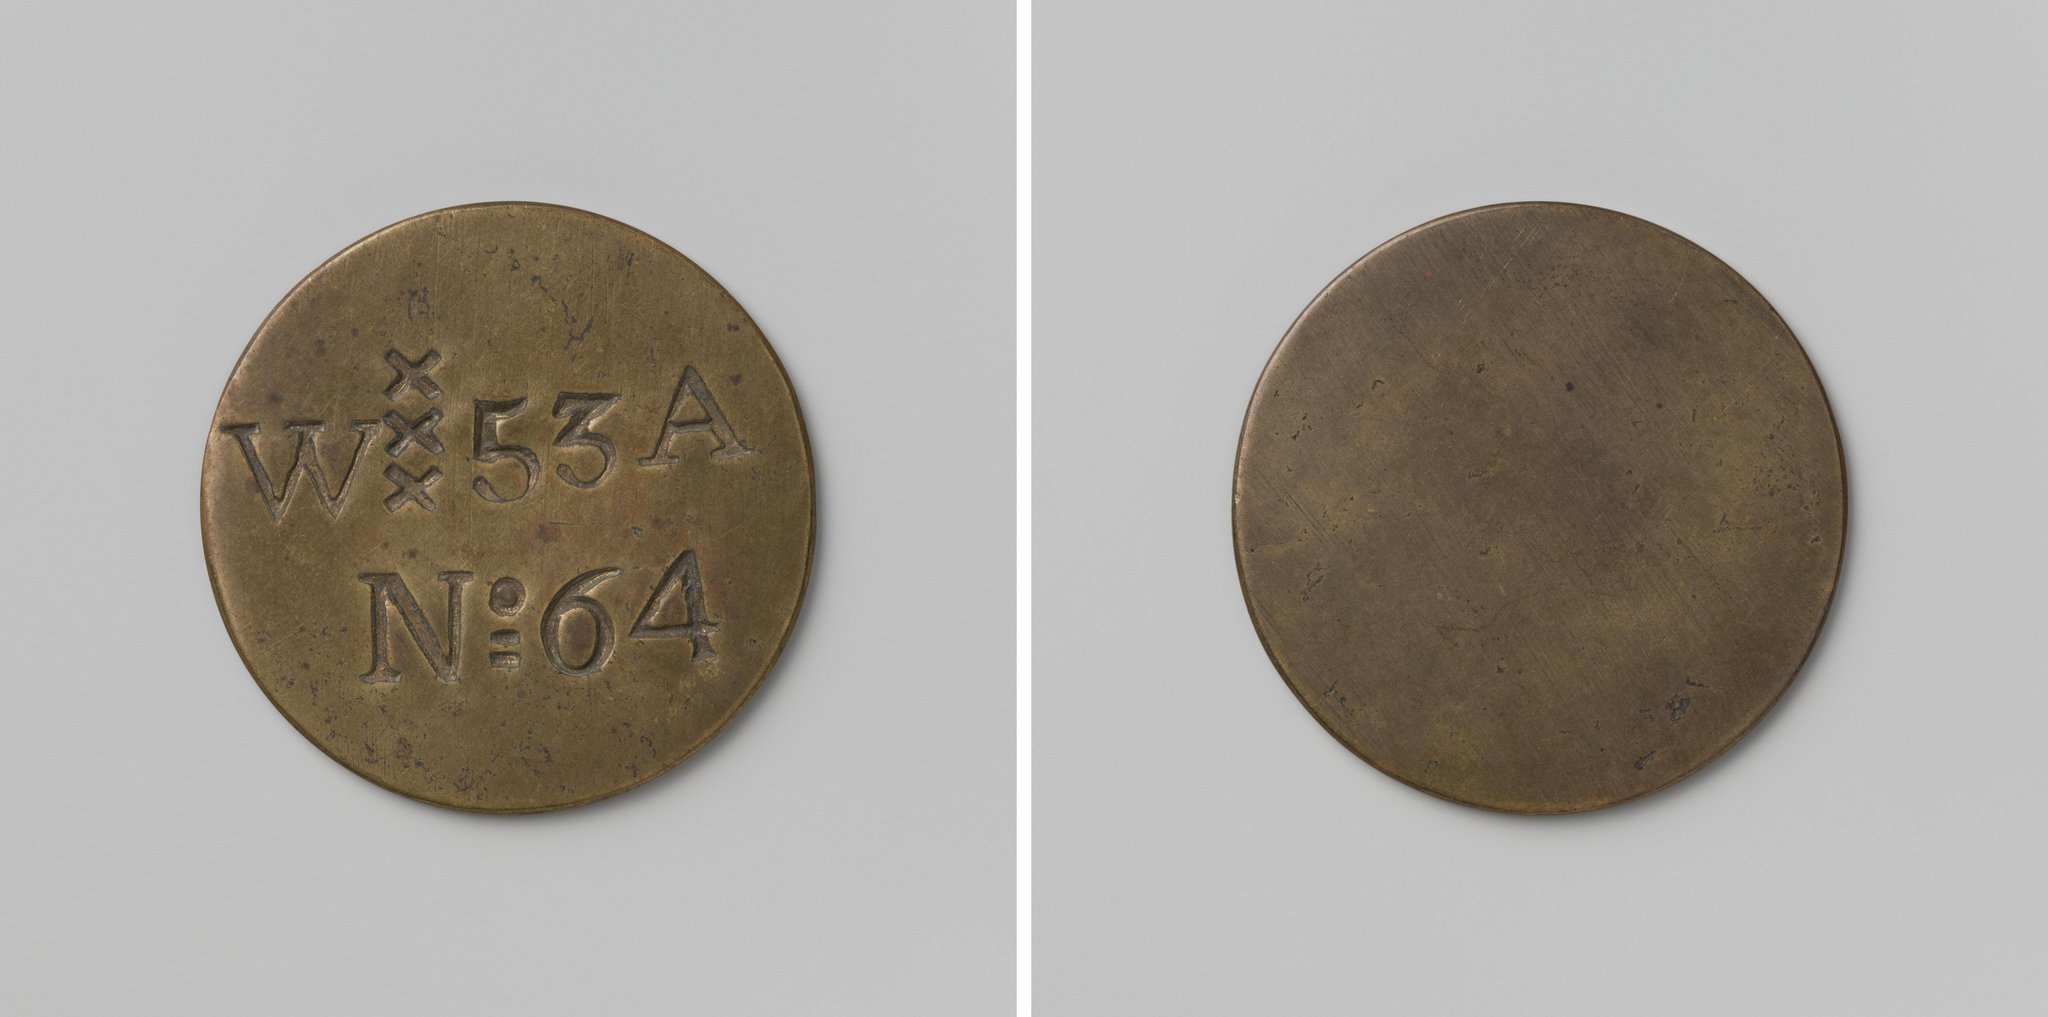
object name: medal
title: Amsterdam, brandspuitpenning van wijk 53 A met no. 64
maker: Anonymous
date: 1831-1857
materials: brass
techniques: engraving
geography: amsterdam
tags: amsterdam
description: Eenzijdige messing penning. Voorzijde: opschrift W 53 A, onderbroken door drie boven elkaar geplaatste kruisjes; daaronder: opschrift No. 64. Keerzijde: blanco